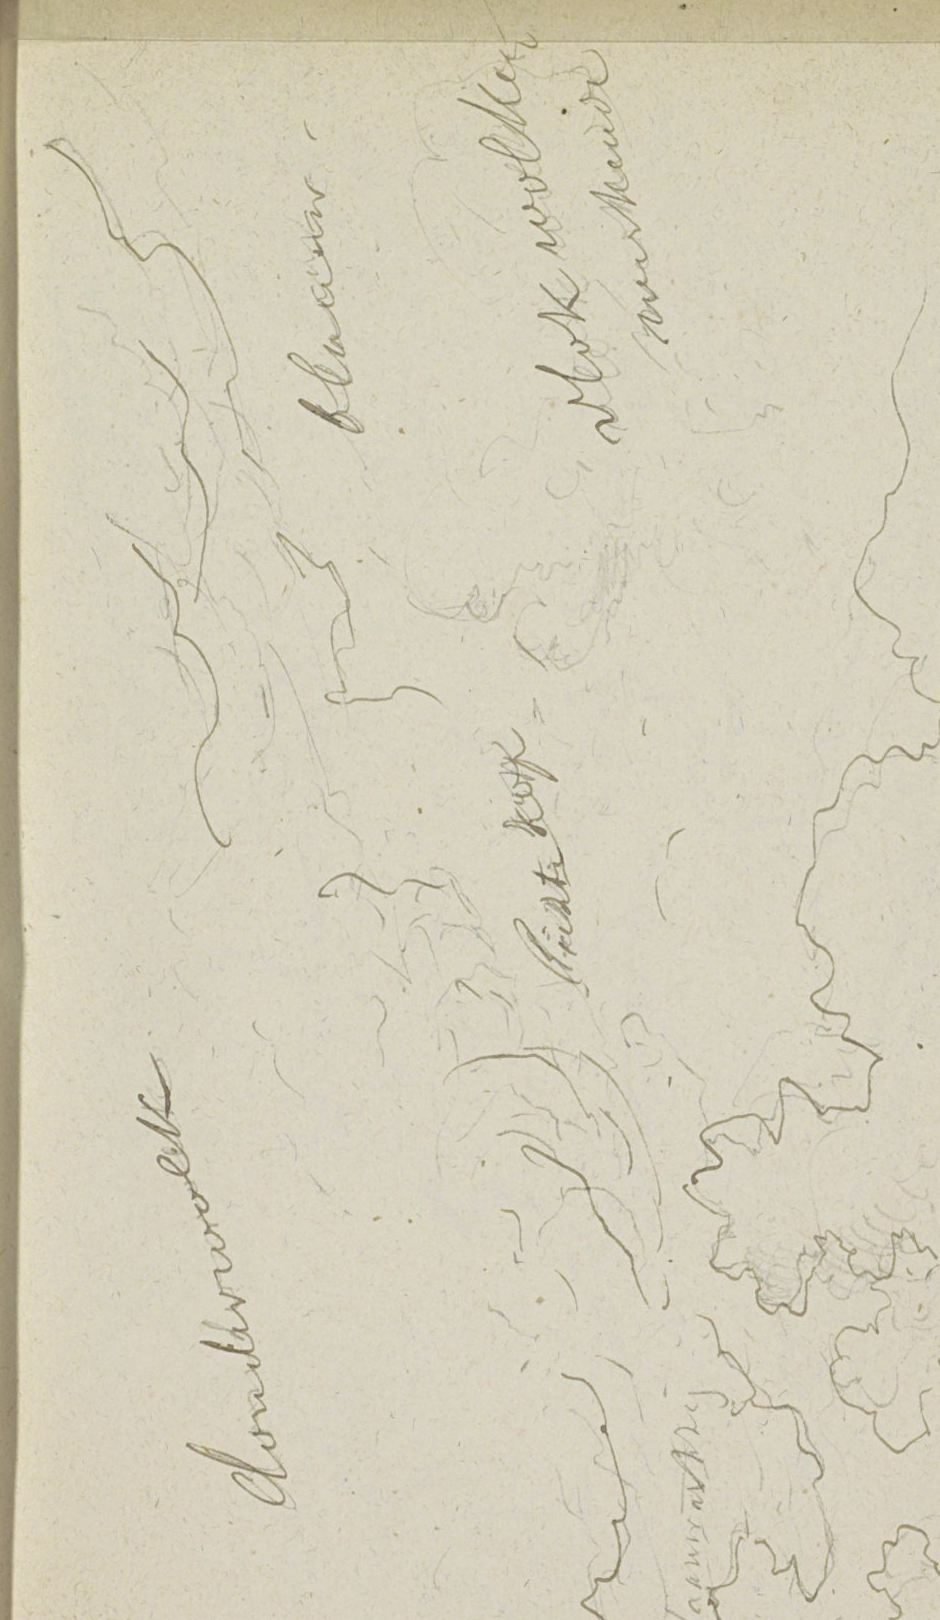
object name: sketchbook leaf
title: Donderwolken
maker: johannes tavenraat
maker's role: draughtsman, painter, print maker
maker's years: 1809-1881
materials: ink, paper, pencil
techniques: pen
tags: clouds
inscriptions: annotation: ‘donderwolk’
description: Blad 31 recto uit een schetsboek met 88 bladen.